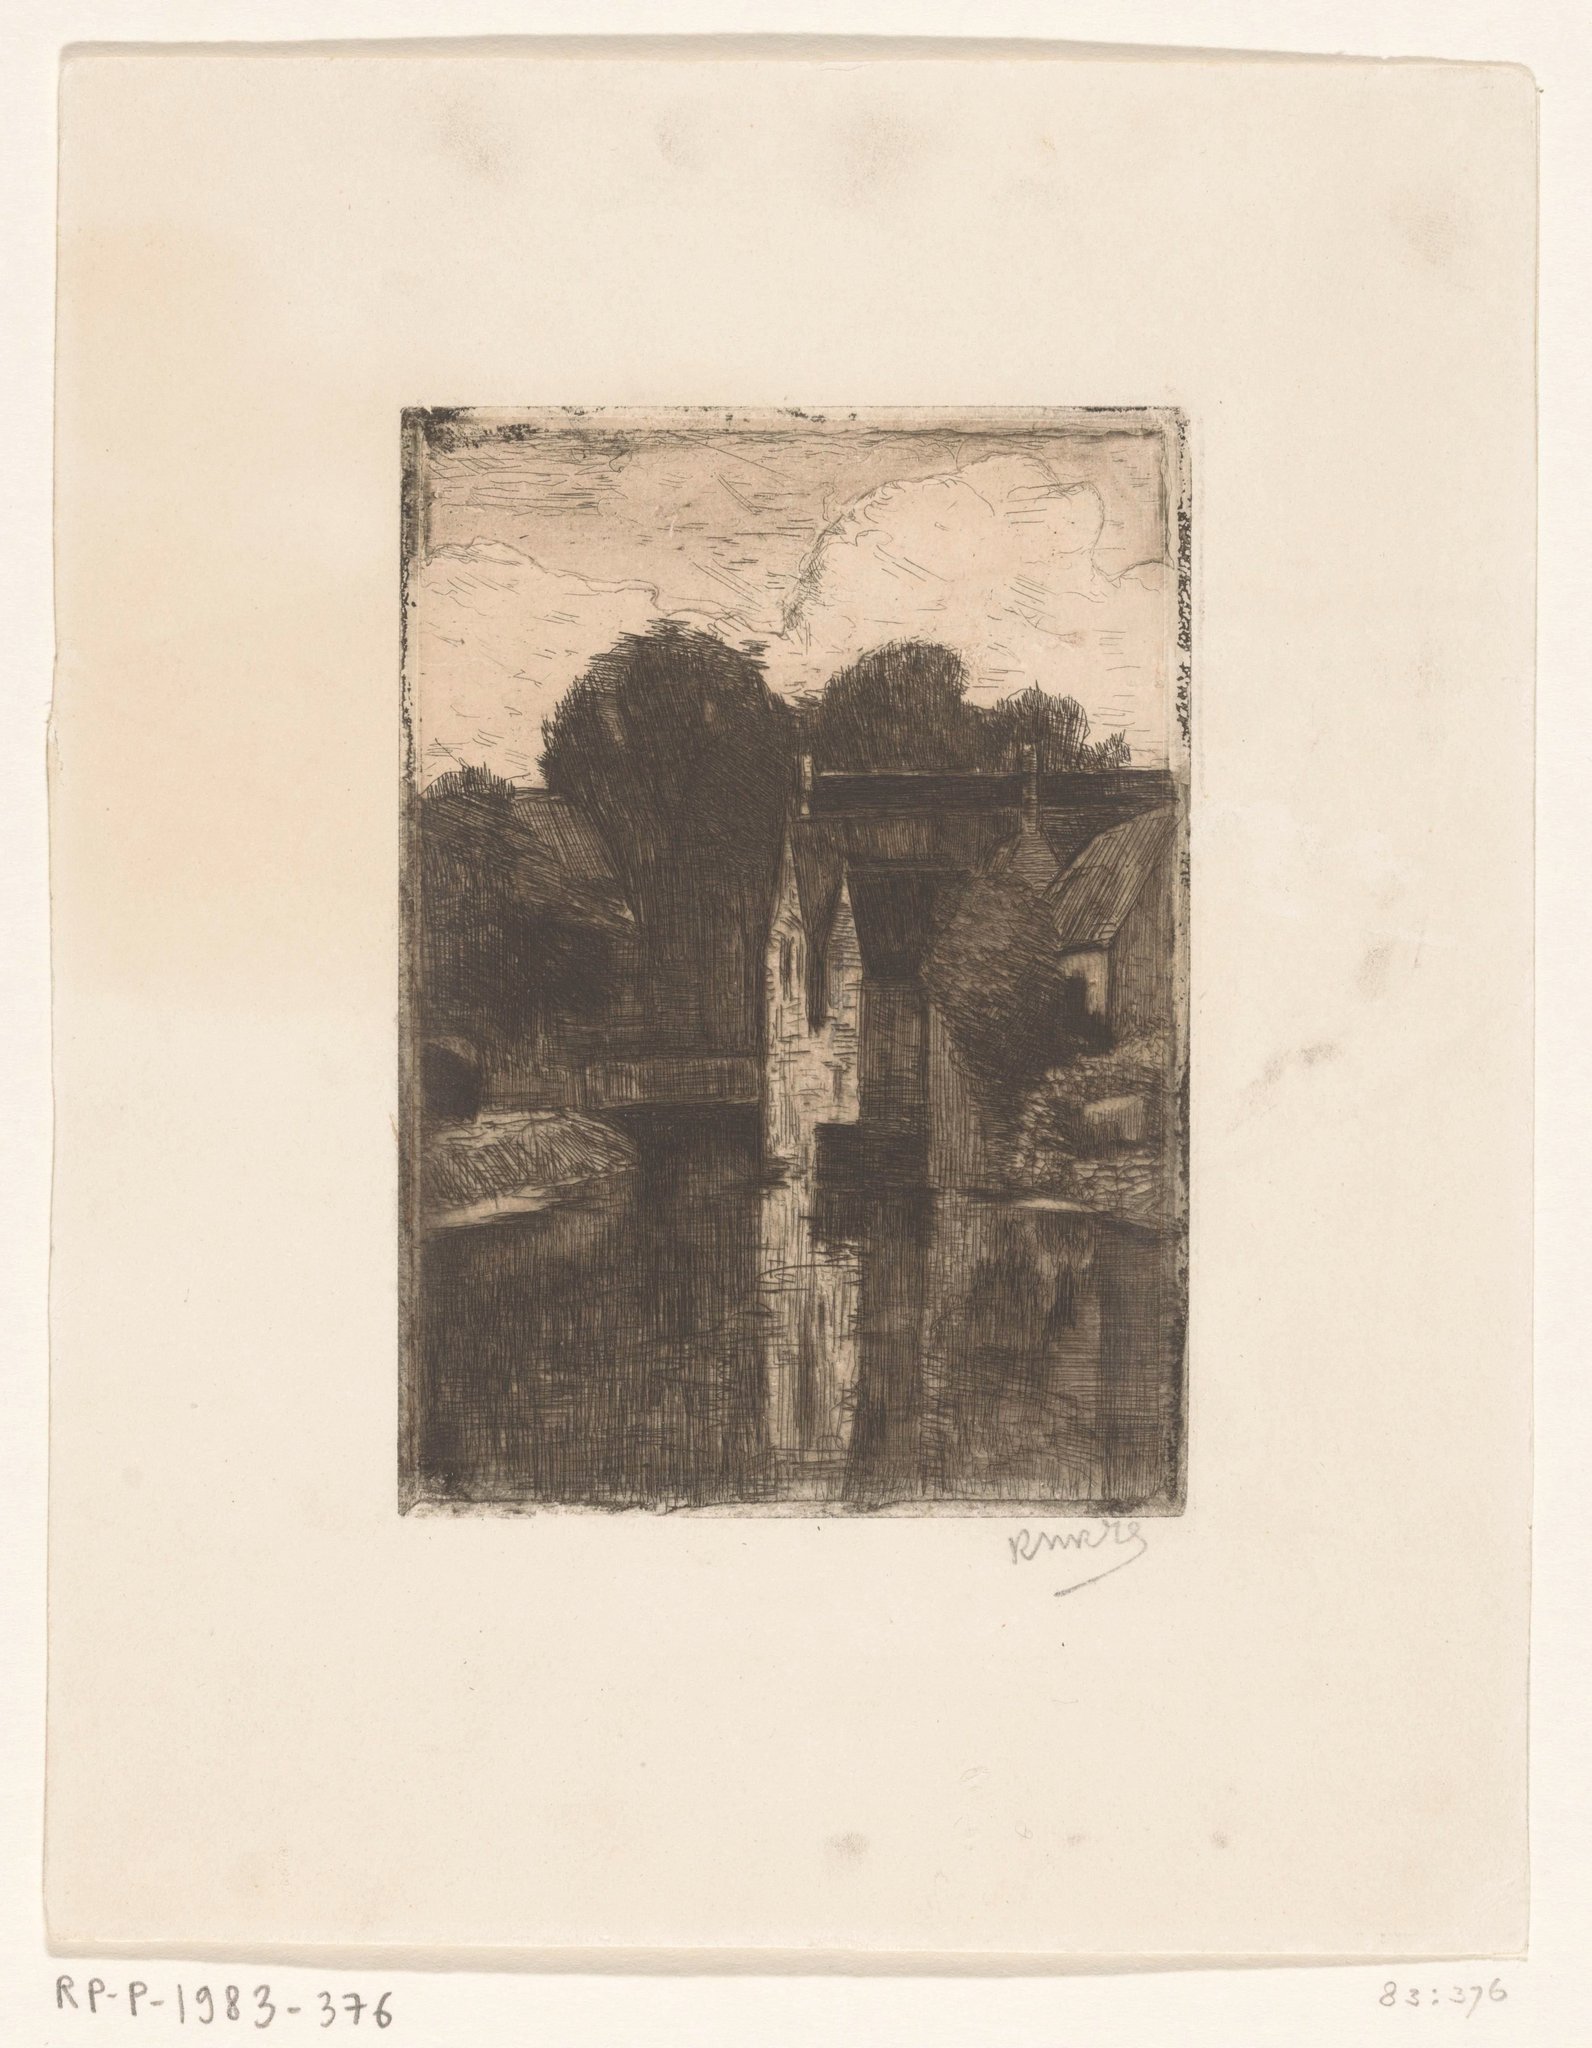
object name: print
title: Huizen aan het water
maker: richard nicolaüs roland holst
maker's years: 1868-1938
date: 1878-1938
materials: paper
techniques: etching, intaglio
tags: landscapes with waters, waterscapes, seascapes (in the temperate zone), housing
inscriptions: collector's mark: Lugt 2760, collector's mark: Lugt 2228